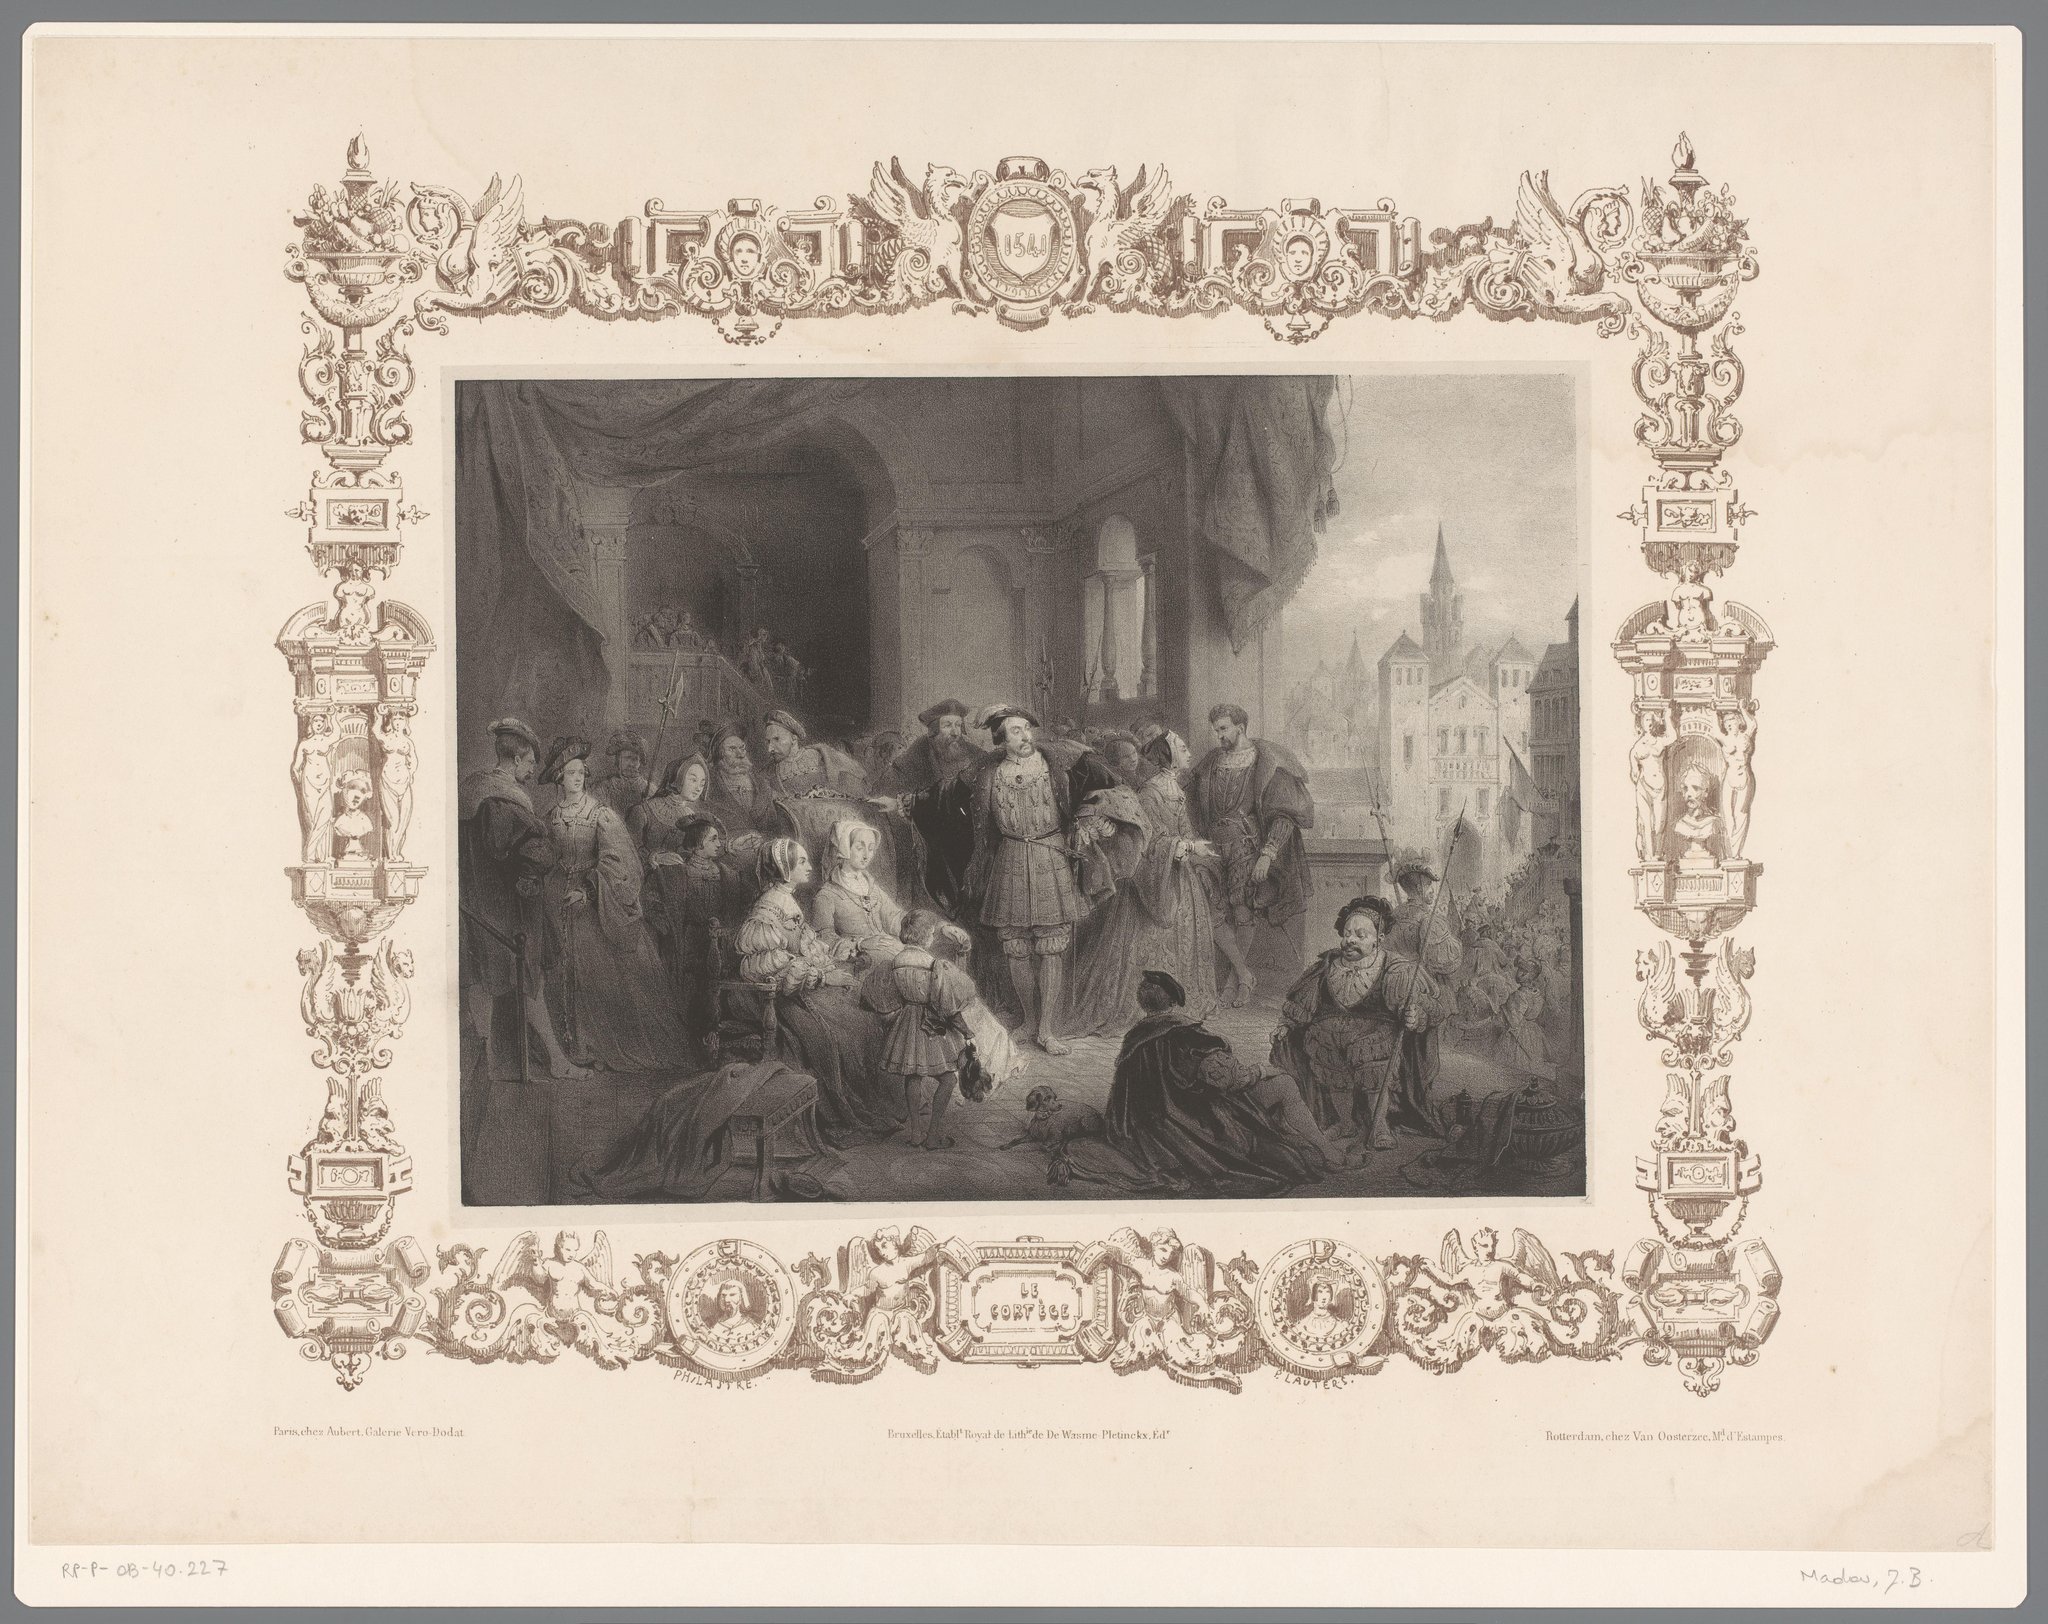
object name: print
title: Fysionomie van de welgestelden in Europa van de vijftiende tot en met de negentiende eeuw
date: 1835-1837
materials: paper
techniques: lithograph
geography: rotterdam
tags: court ceremonial, court etiquette, procession ~ christian religion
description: De voorstelling is vervaardigd door Madou, de omlijsting door Paulus Lauters en Philastre.